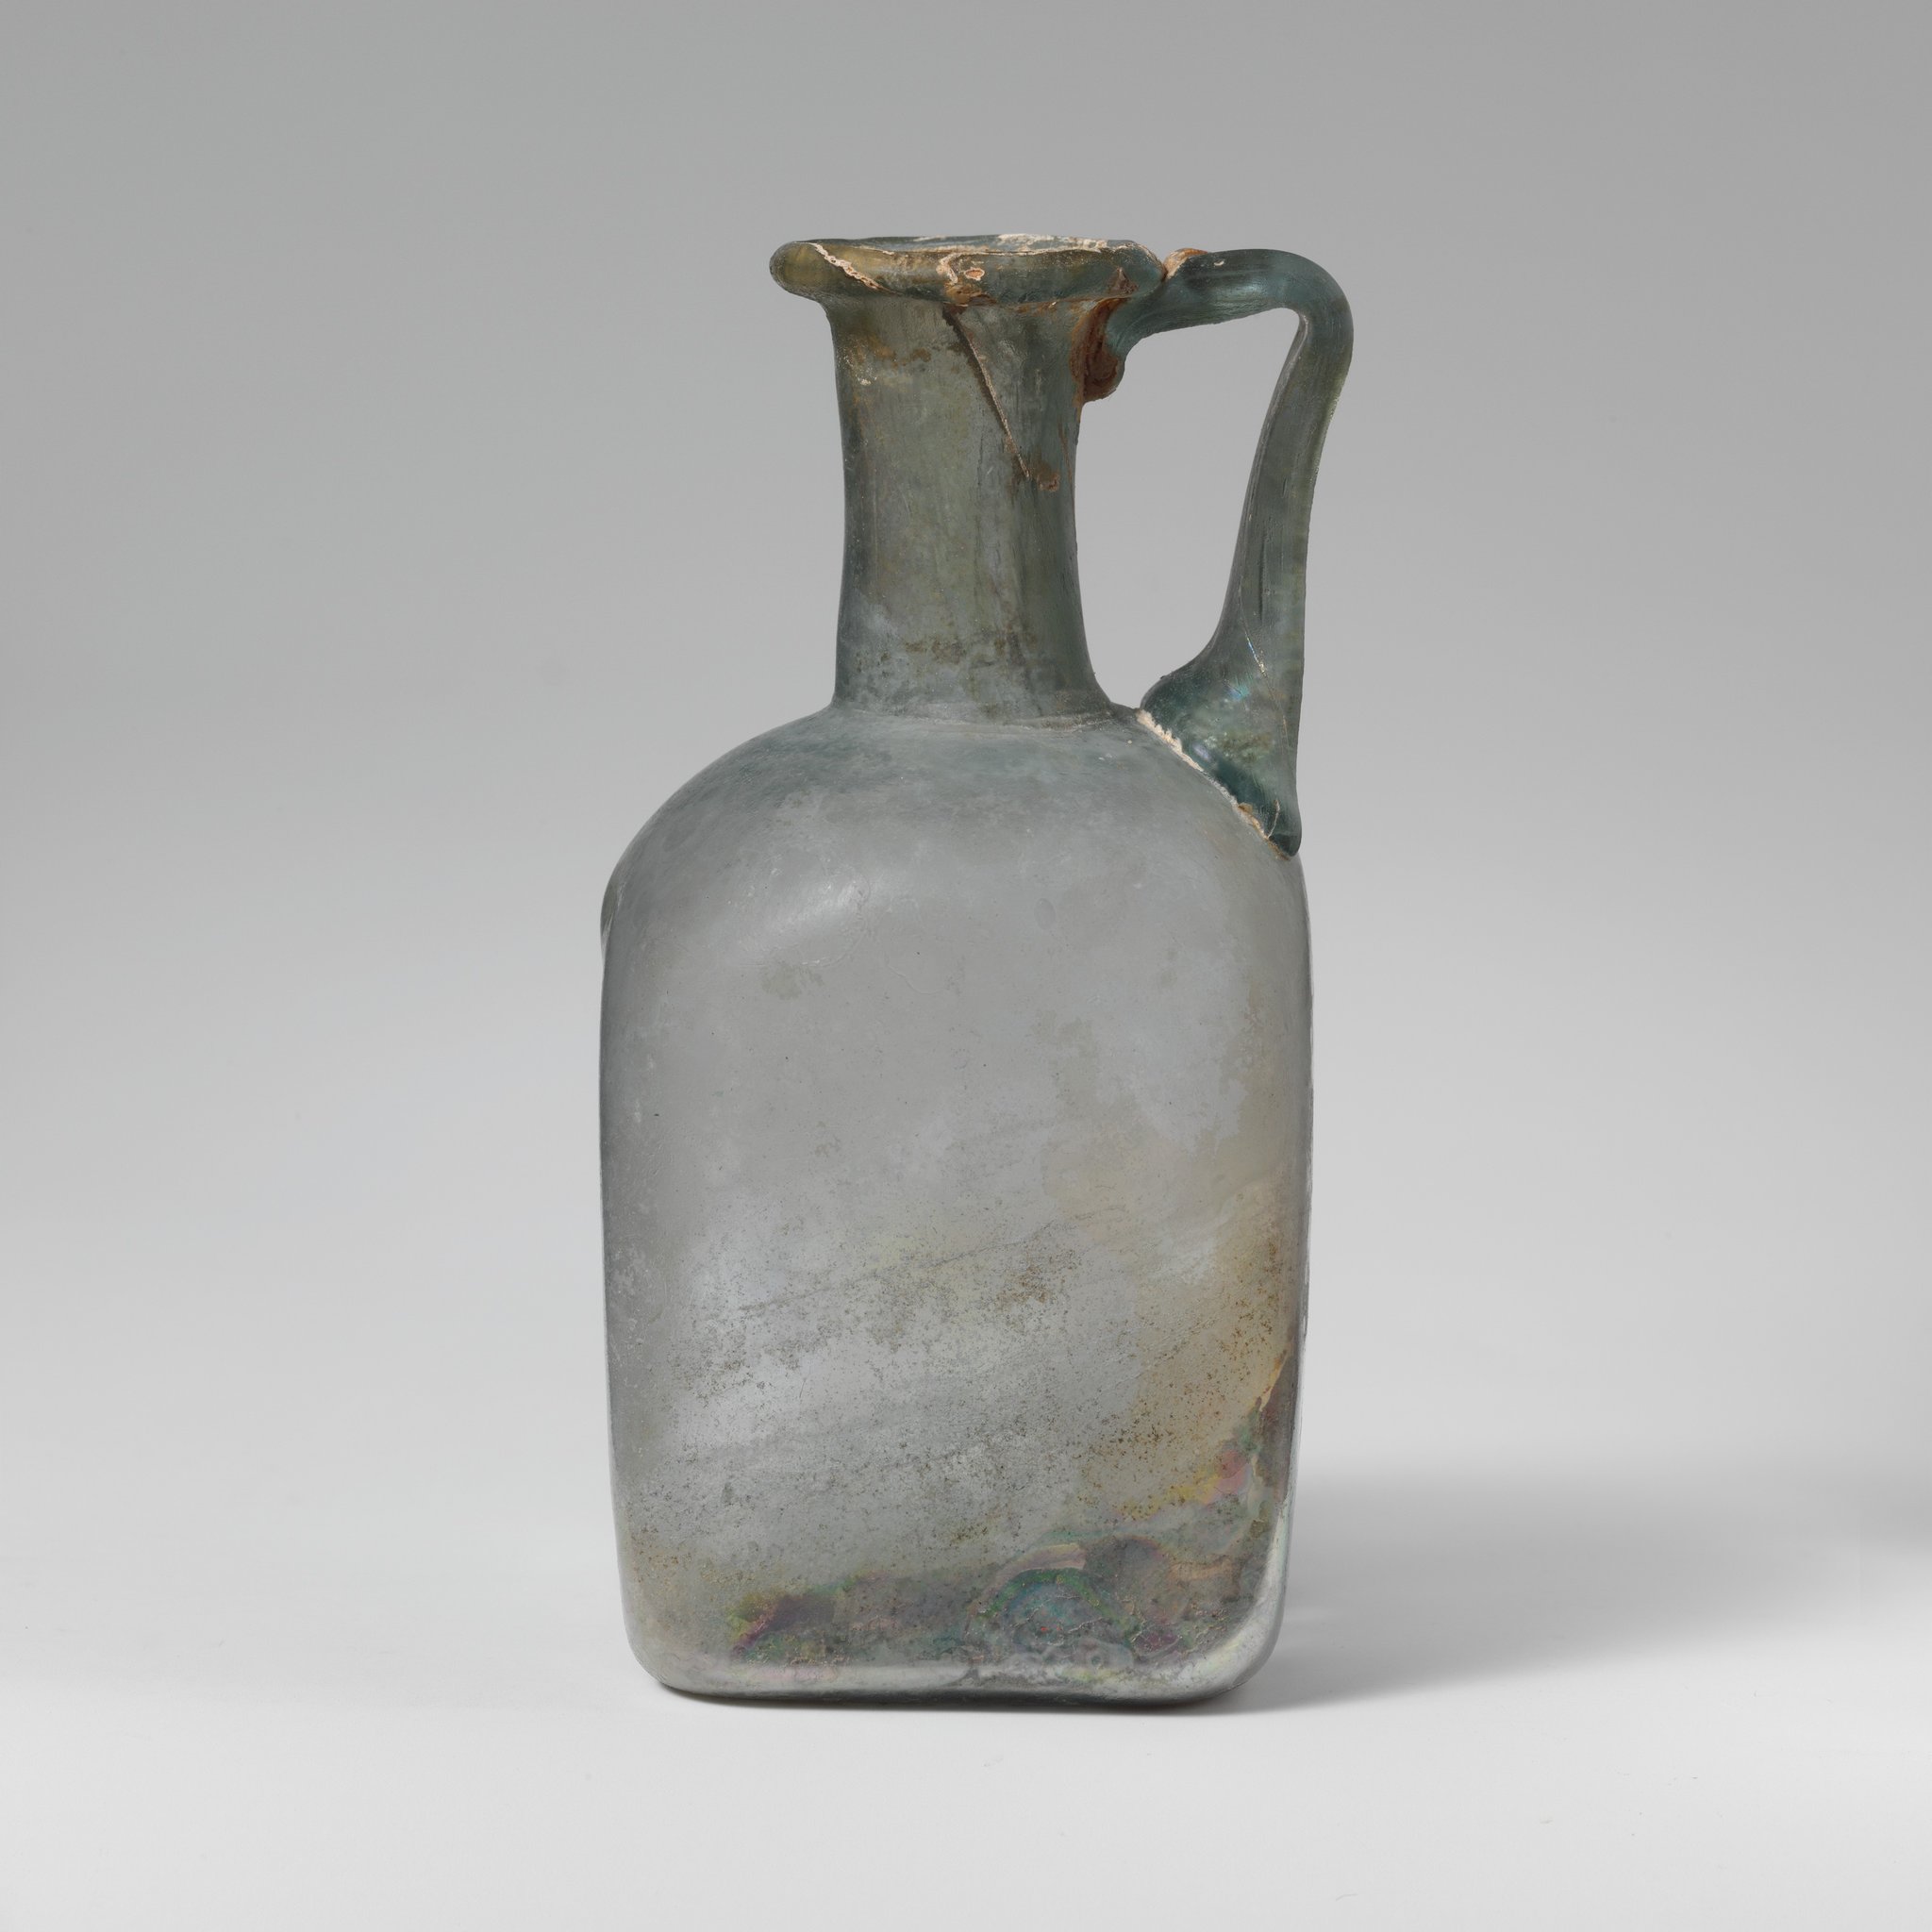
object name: bottle, square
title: Glass square bottle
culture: roman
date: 101-300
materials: glass